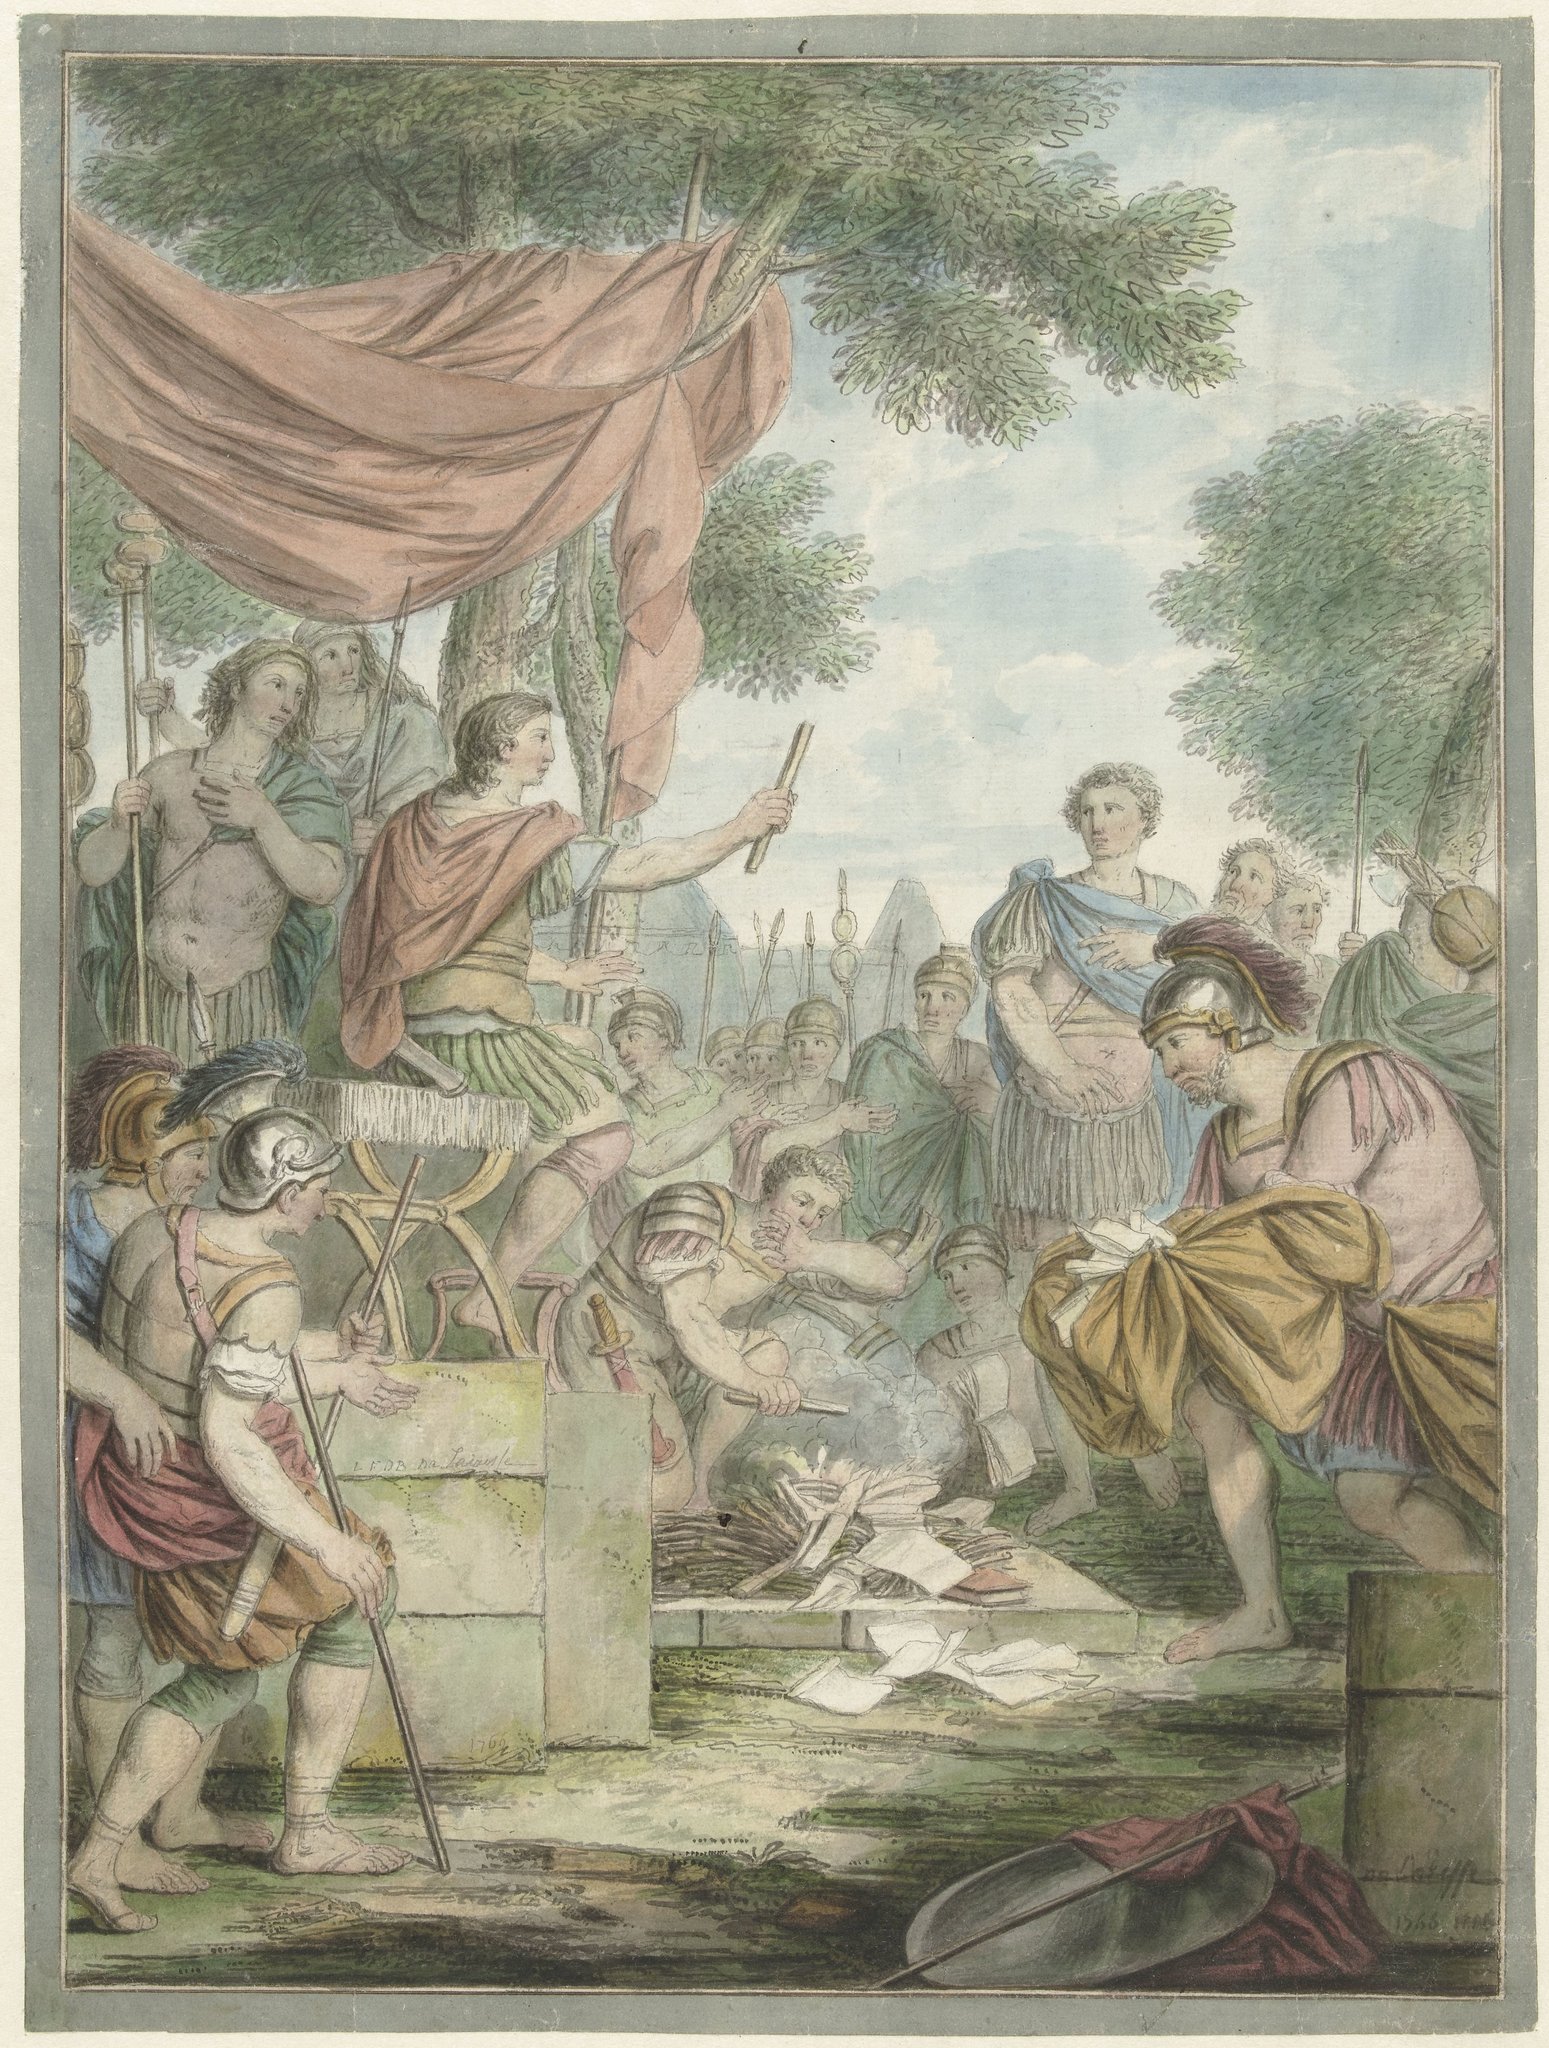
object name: drawing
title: Pompeius laat de brieven van Sertorius verbranden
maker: louis fabritius dubourg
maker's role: draughtsman, print maker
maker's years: 1693-1775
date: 1766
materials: ink, paper, watercolor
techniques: brush, pen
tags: male persons from classical history (sertorius) - non-aggressive activities of person from classical history, augustus has the letters of sextus pompeius destroyed, (story of) sextus pompeius - aggressive relationships of person from classical history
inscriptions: date: ‘1766’